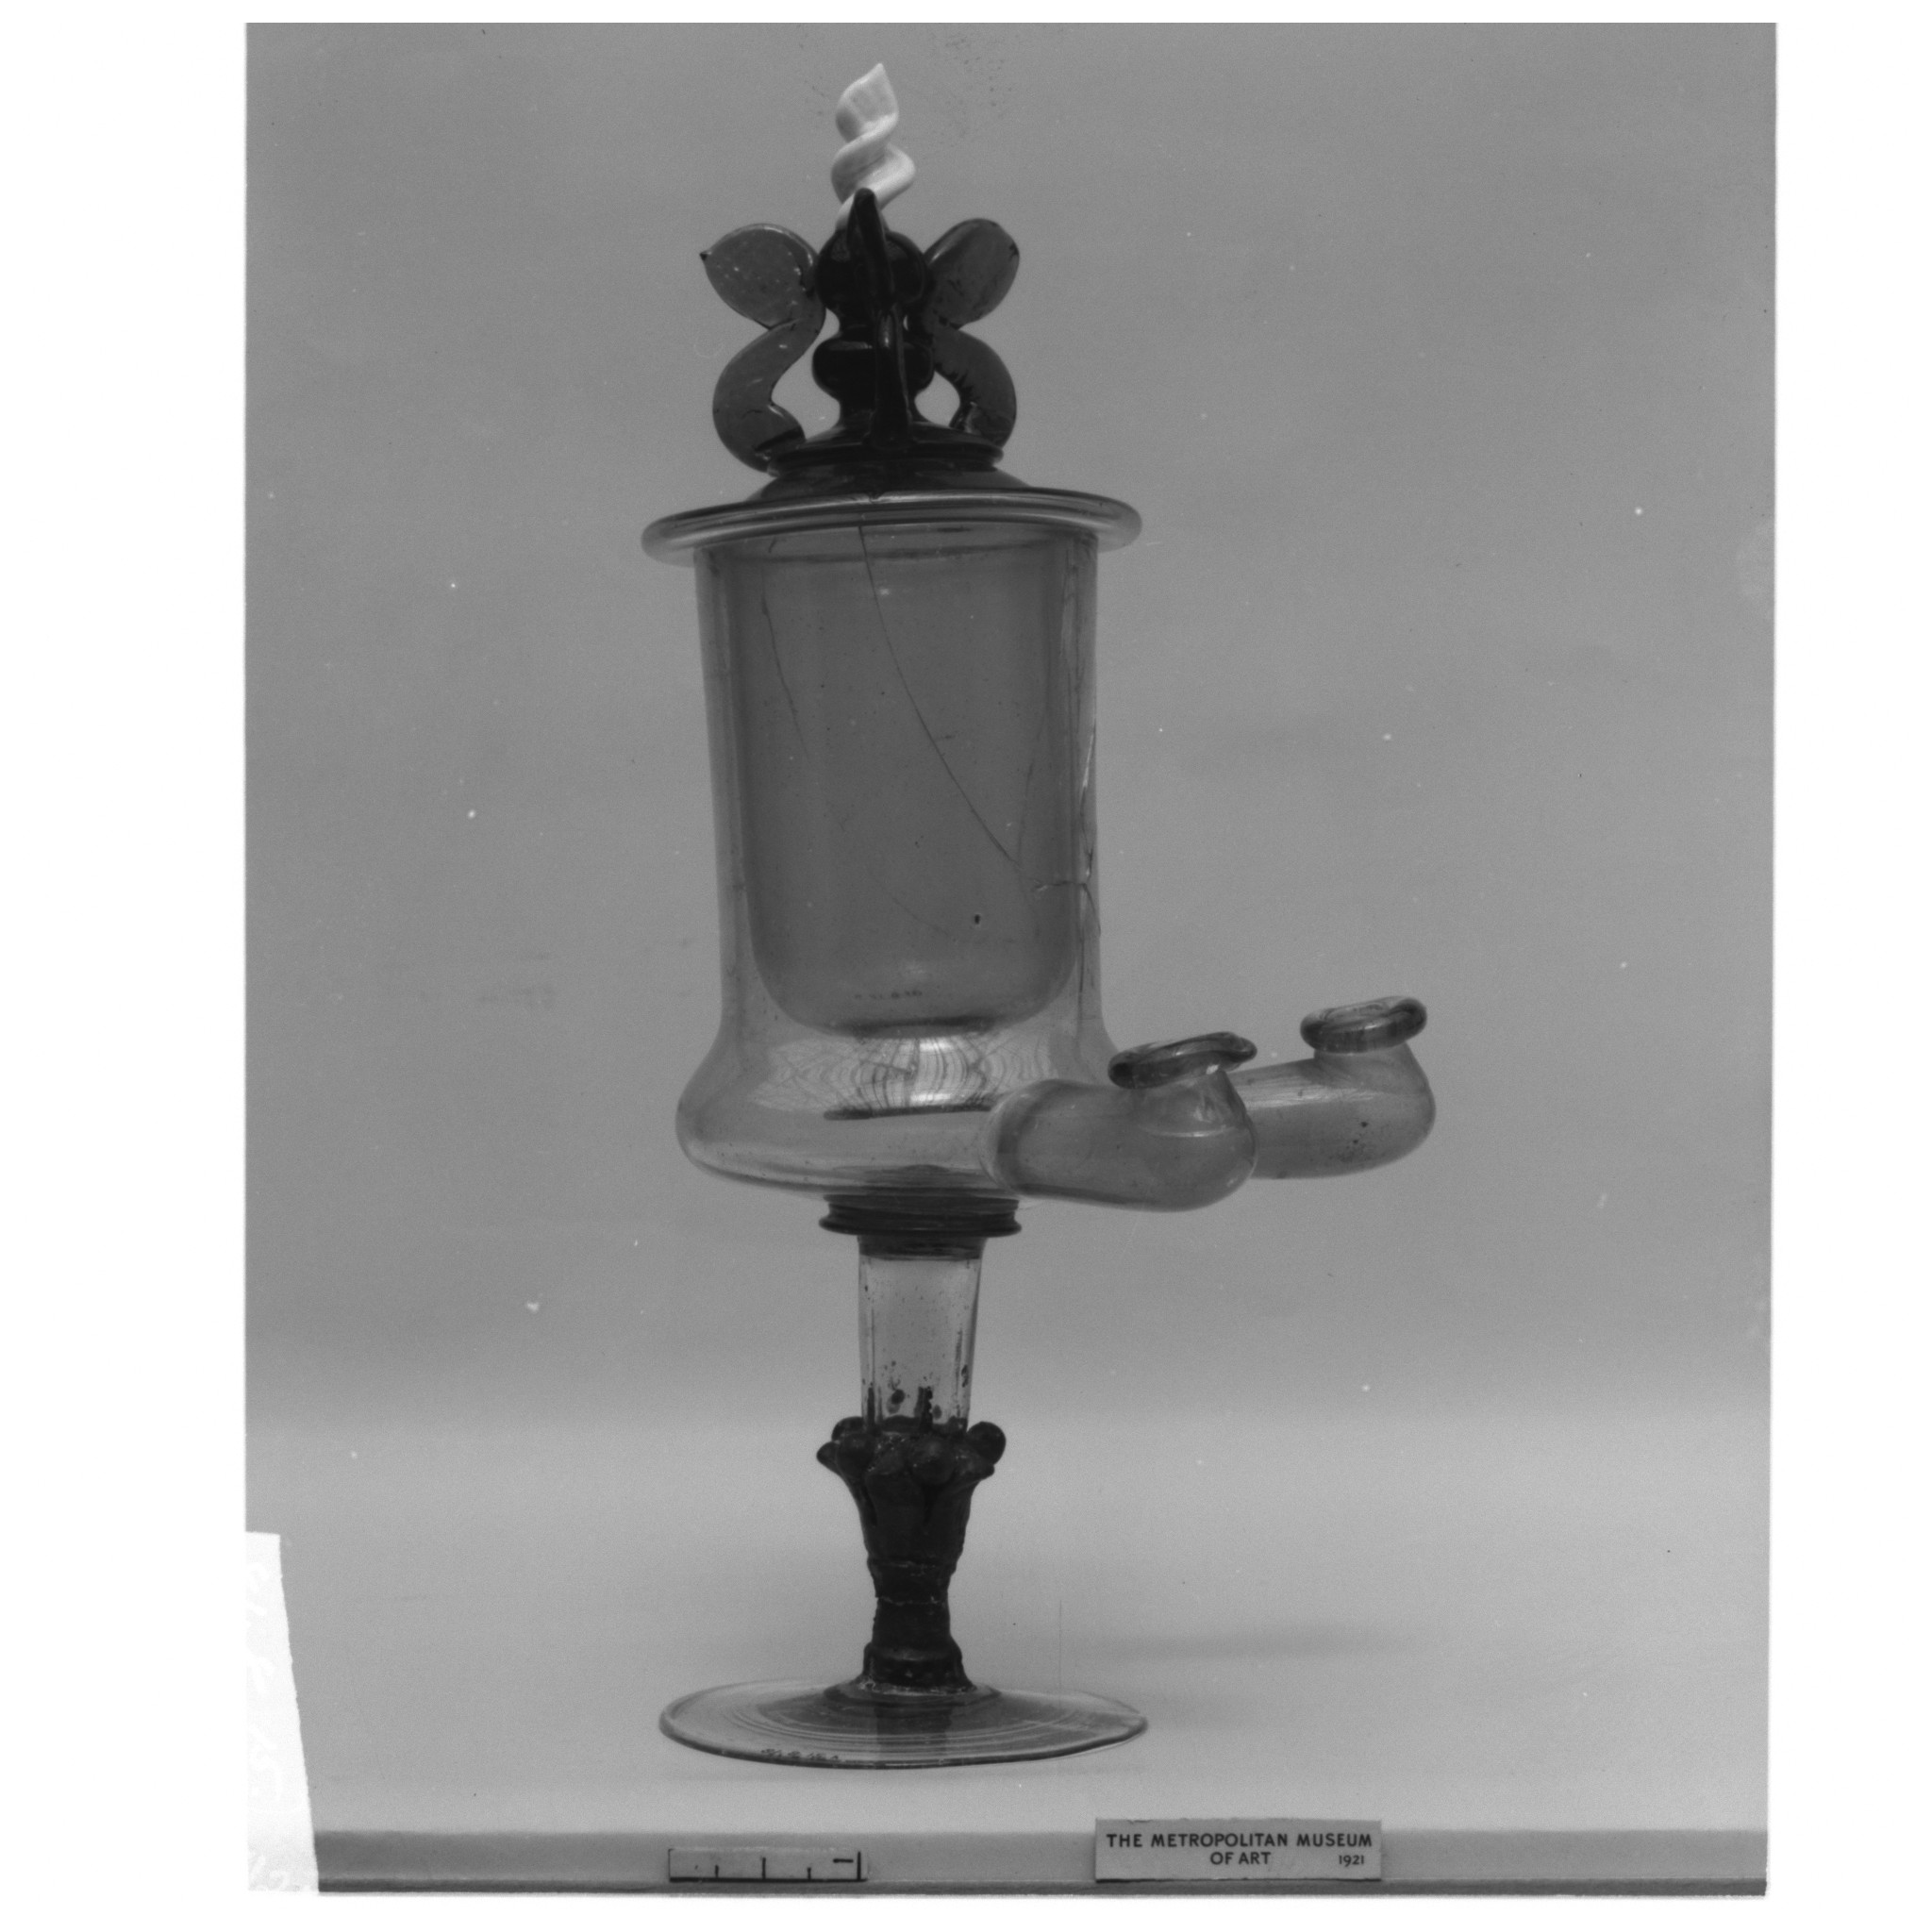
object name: lamp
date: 1701-1800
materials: glass